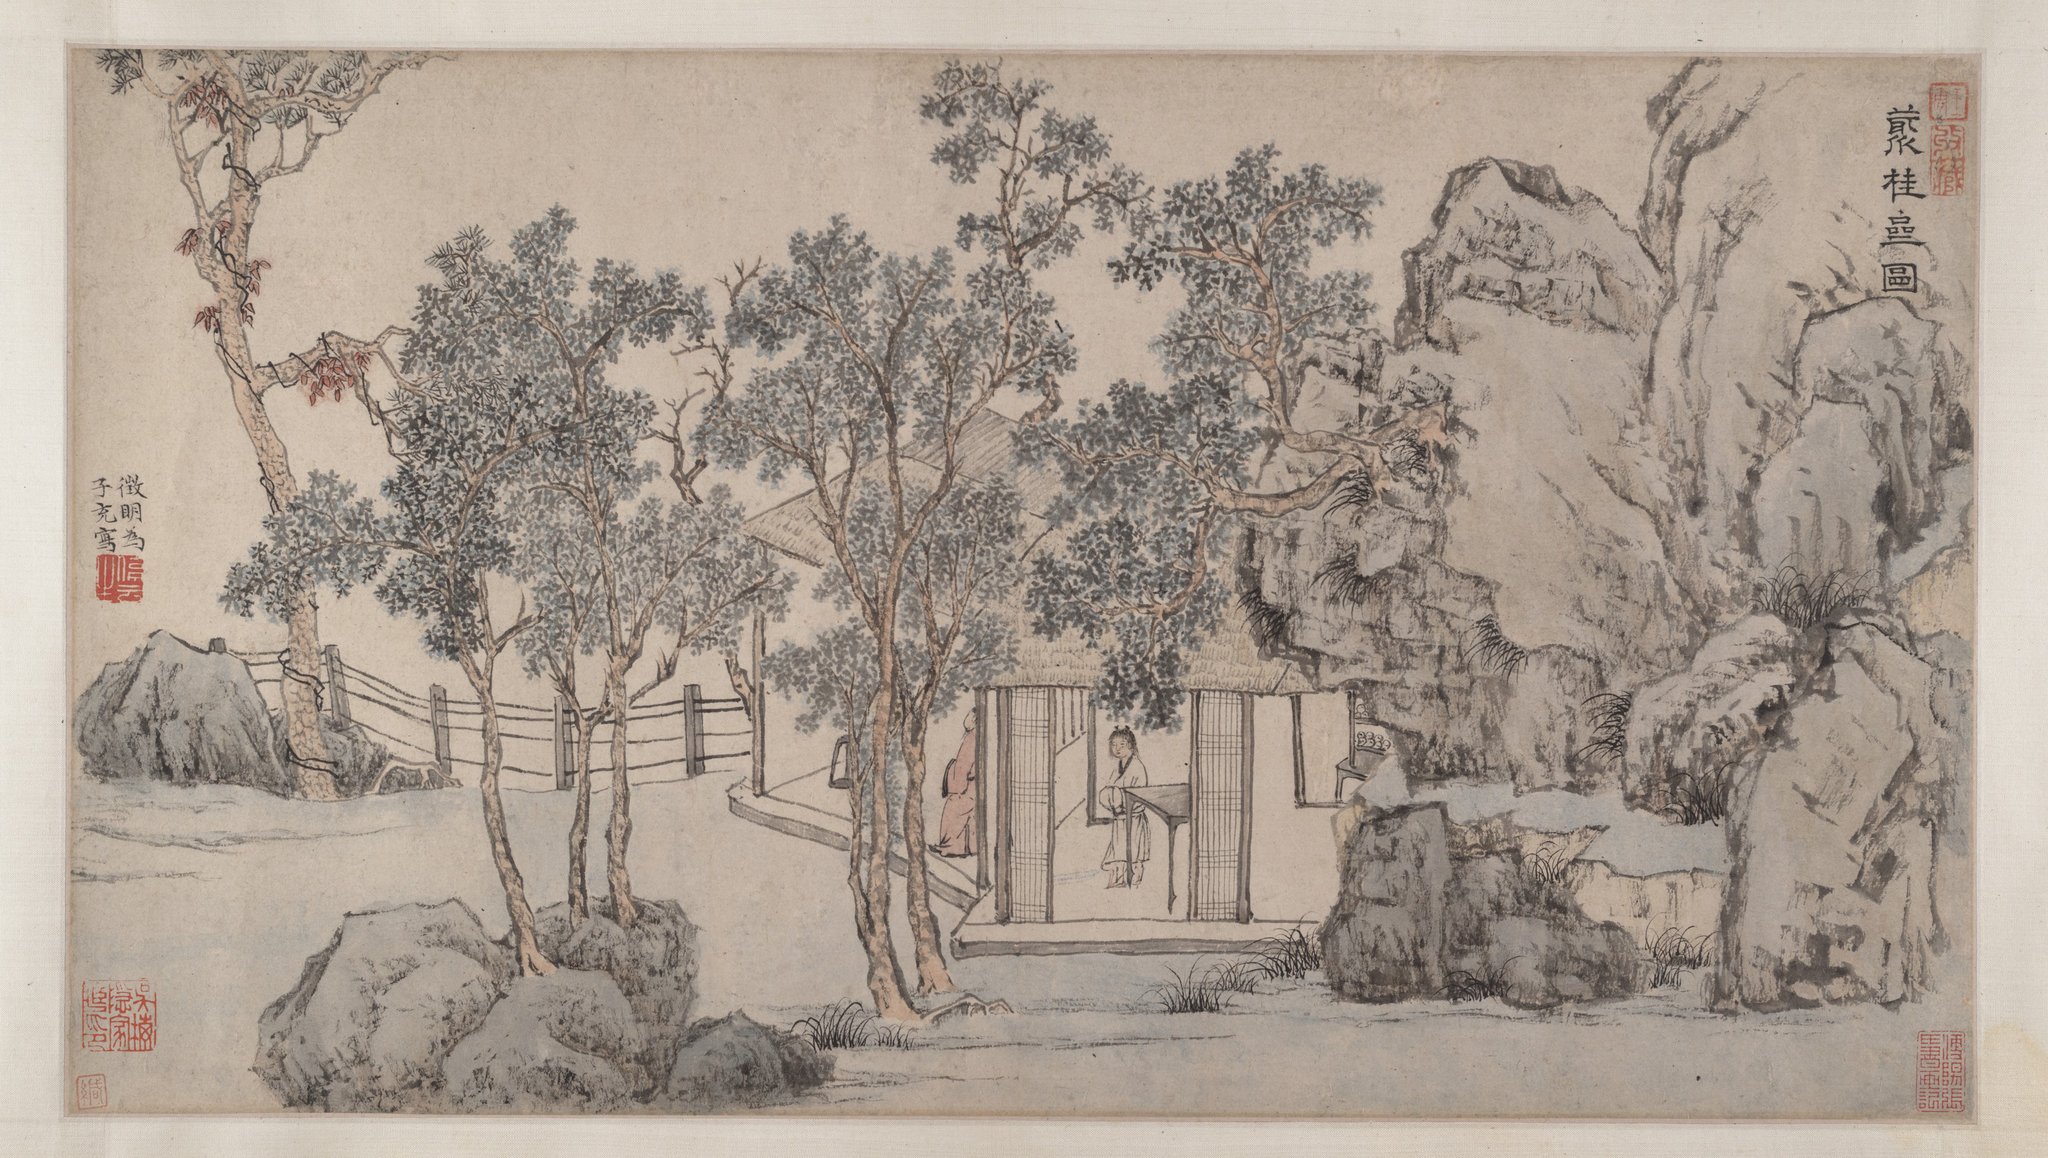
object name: handscroll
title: The Cassia Grove Studio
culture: chinese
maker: wen zhengming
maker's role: artist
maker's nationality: chinese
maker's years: 1470-1559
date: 1532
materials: ink, paper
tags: buildings,landscapes